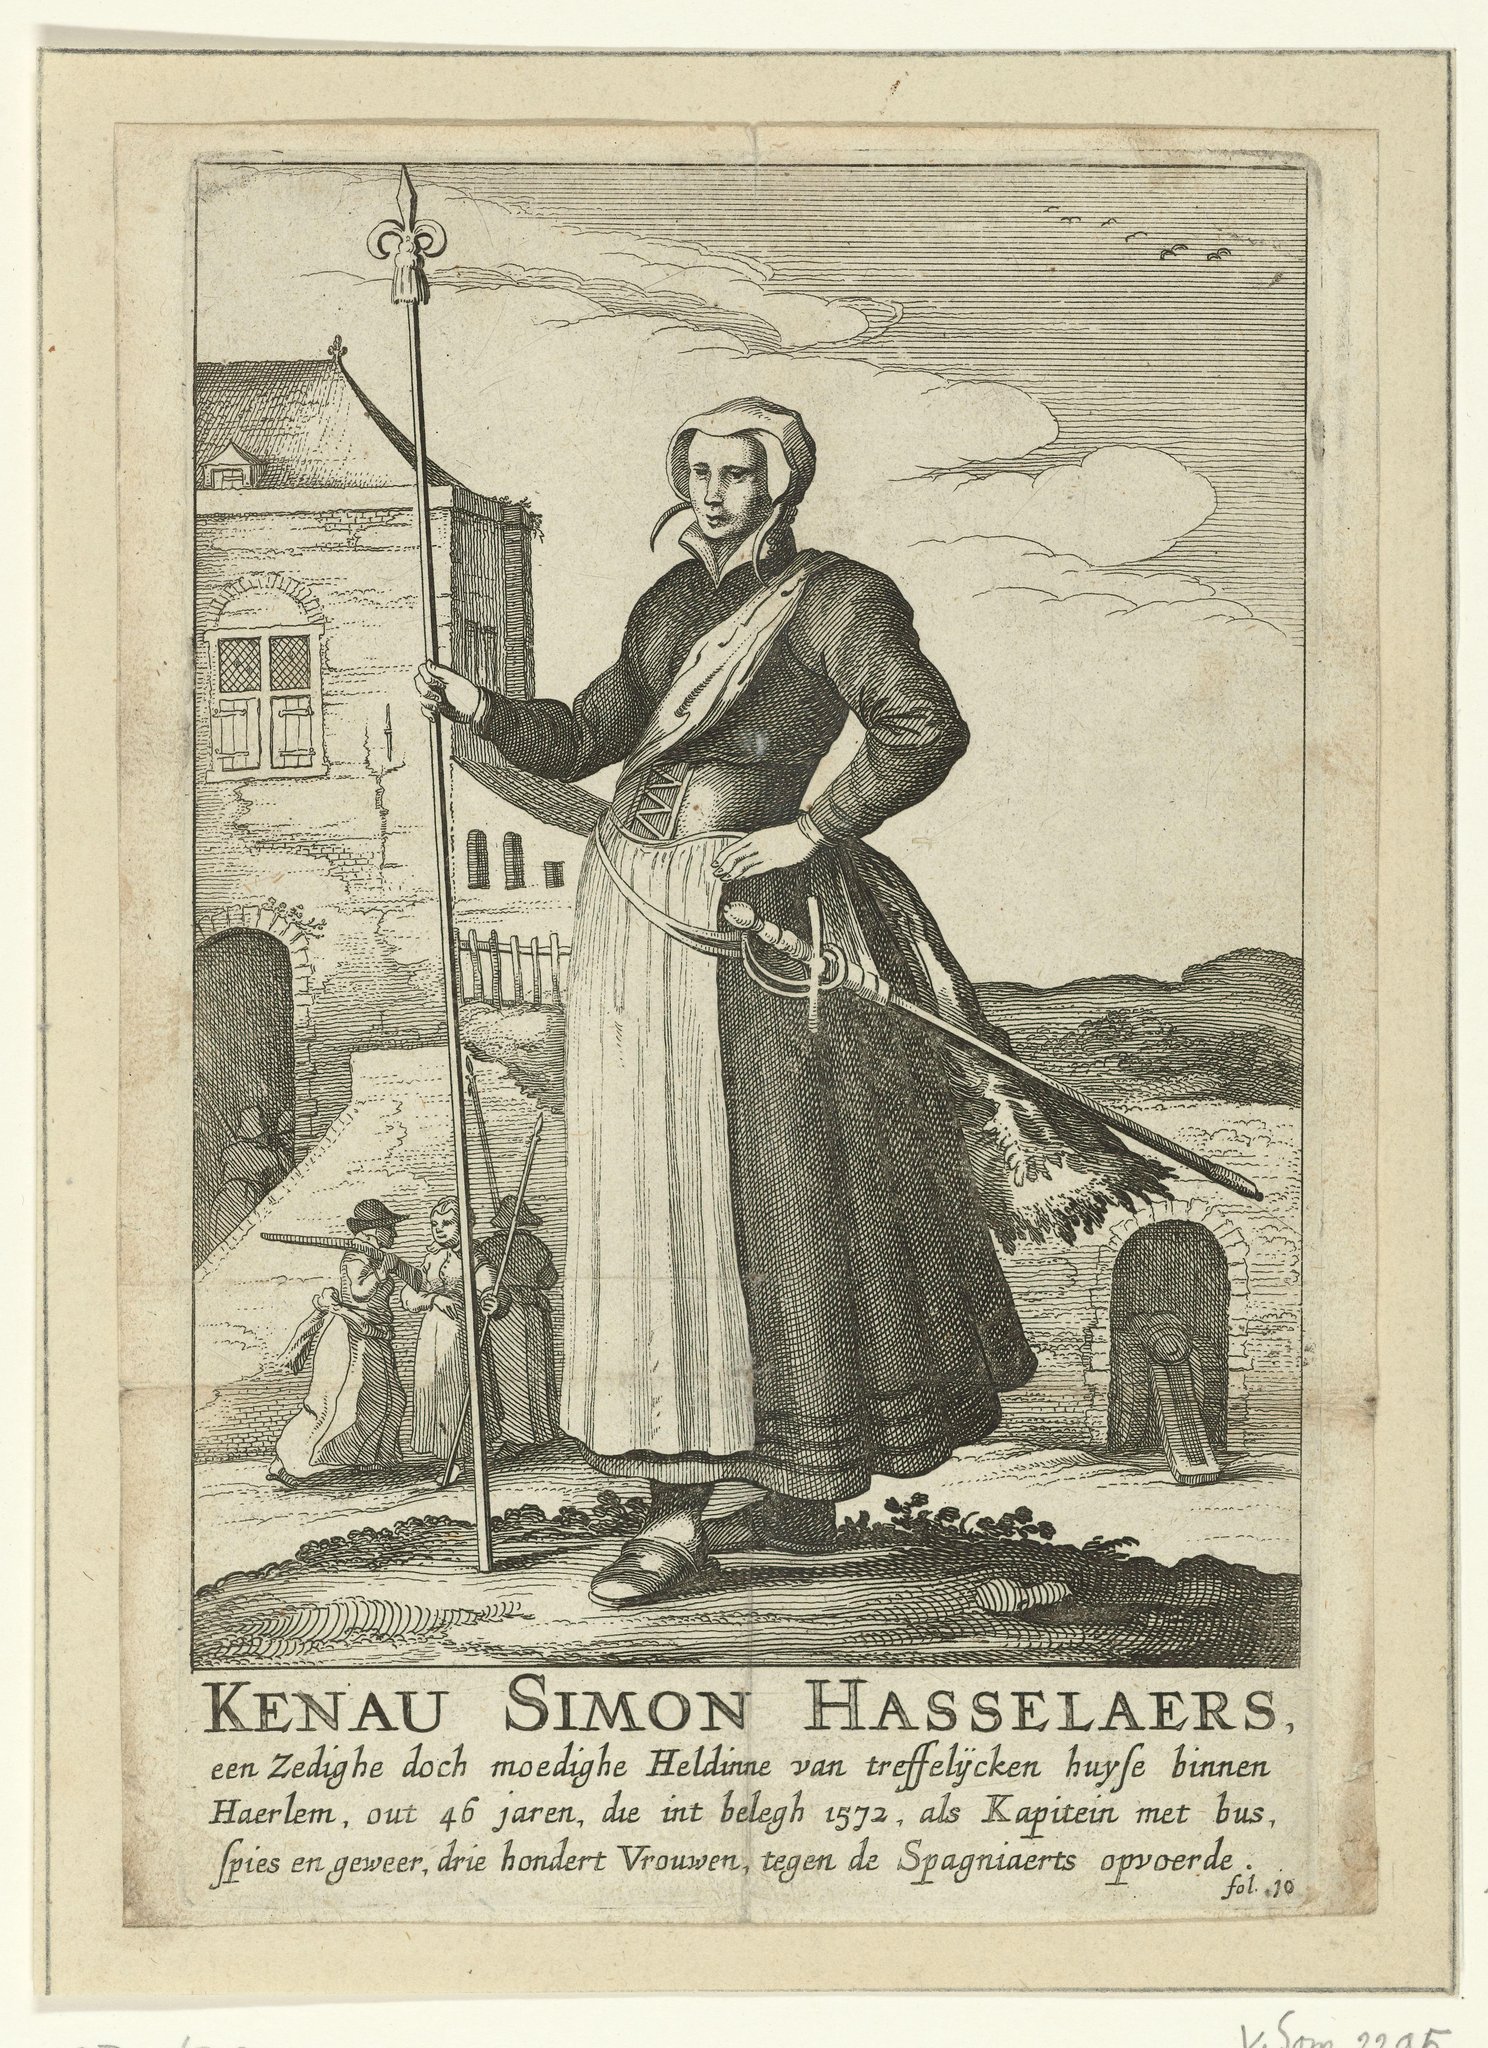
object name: history print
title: Portret van Kenau Simonsdochter Hasselaer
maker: Anonymous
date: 1600-1699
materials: paper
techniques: etching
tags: historical persons - bb - woman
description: Prent met andere foliëring gebruikt in: Pers, Dick Pietersz. De verwarde adelaar, en ontstelde leeuw: waer in de spring-ader der beroerten (...). Amsterdam: Dirck Pietersz. Pers, 1647.